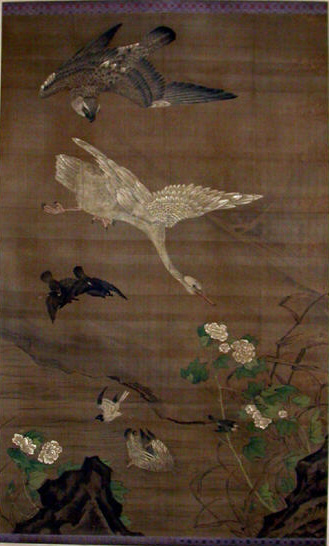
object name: hanging scroll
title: Birds Pursued by an Eagle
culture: japanese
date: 1667-1700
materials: ink, silk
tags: ducks,eagles,swans